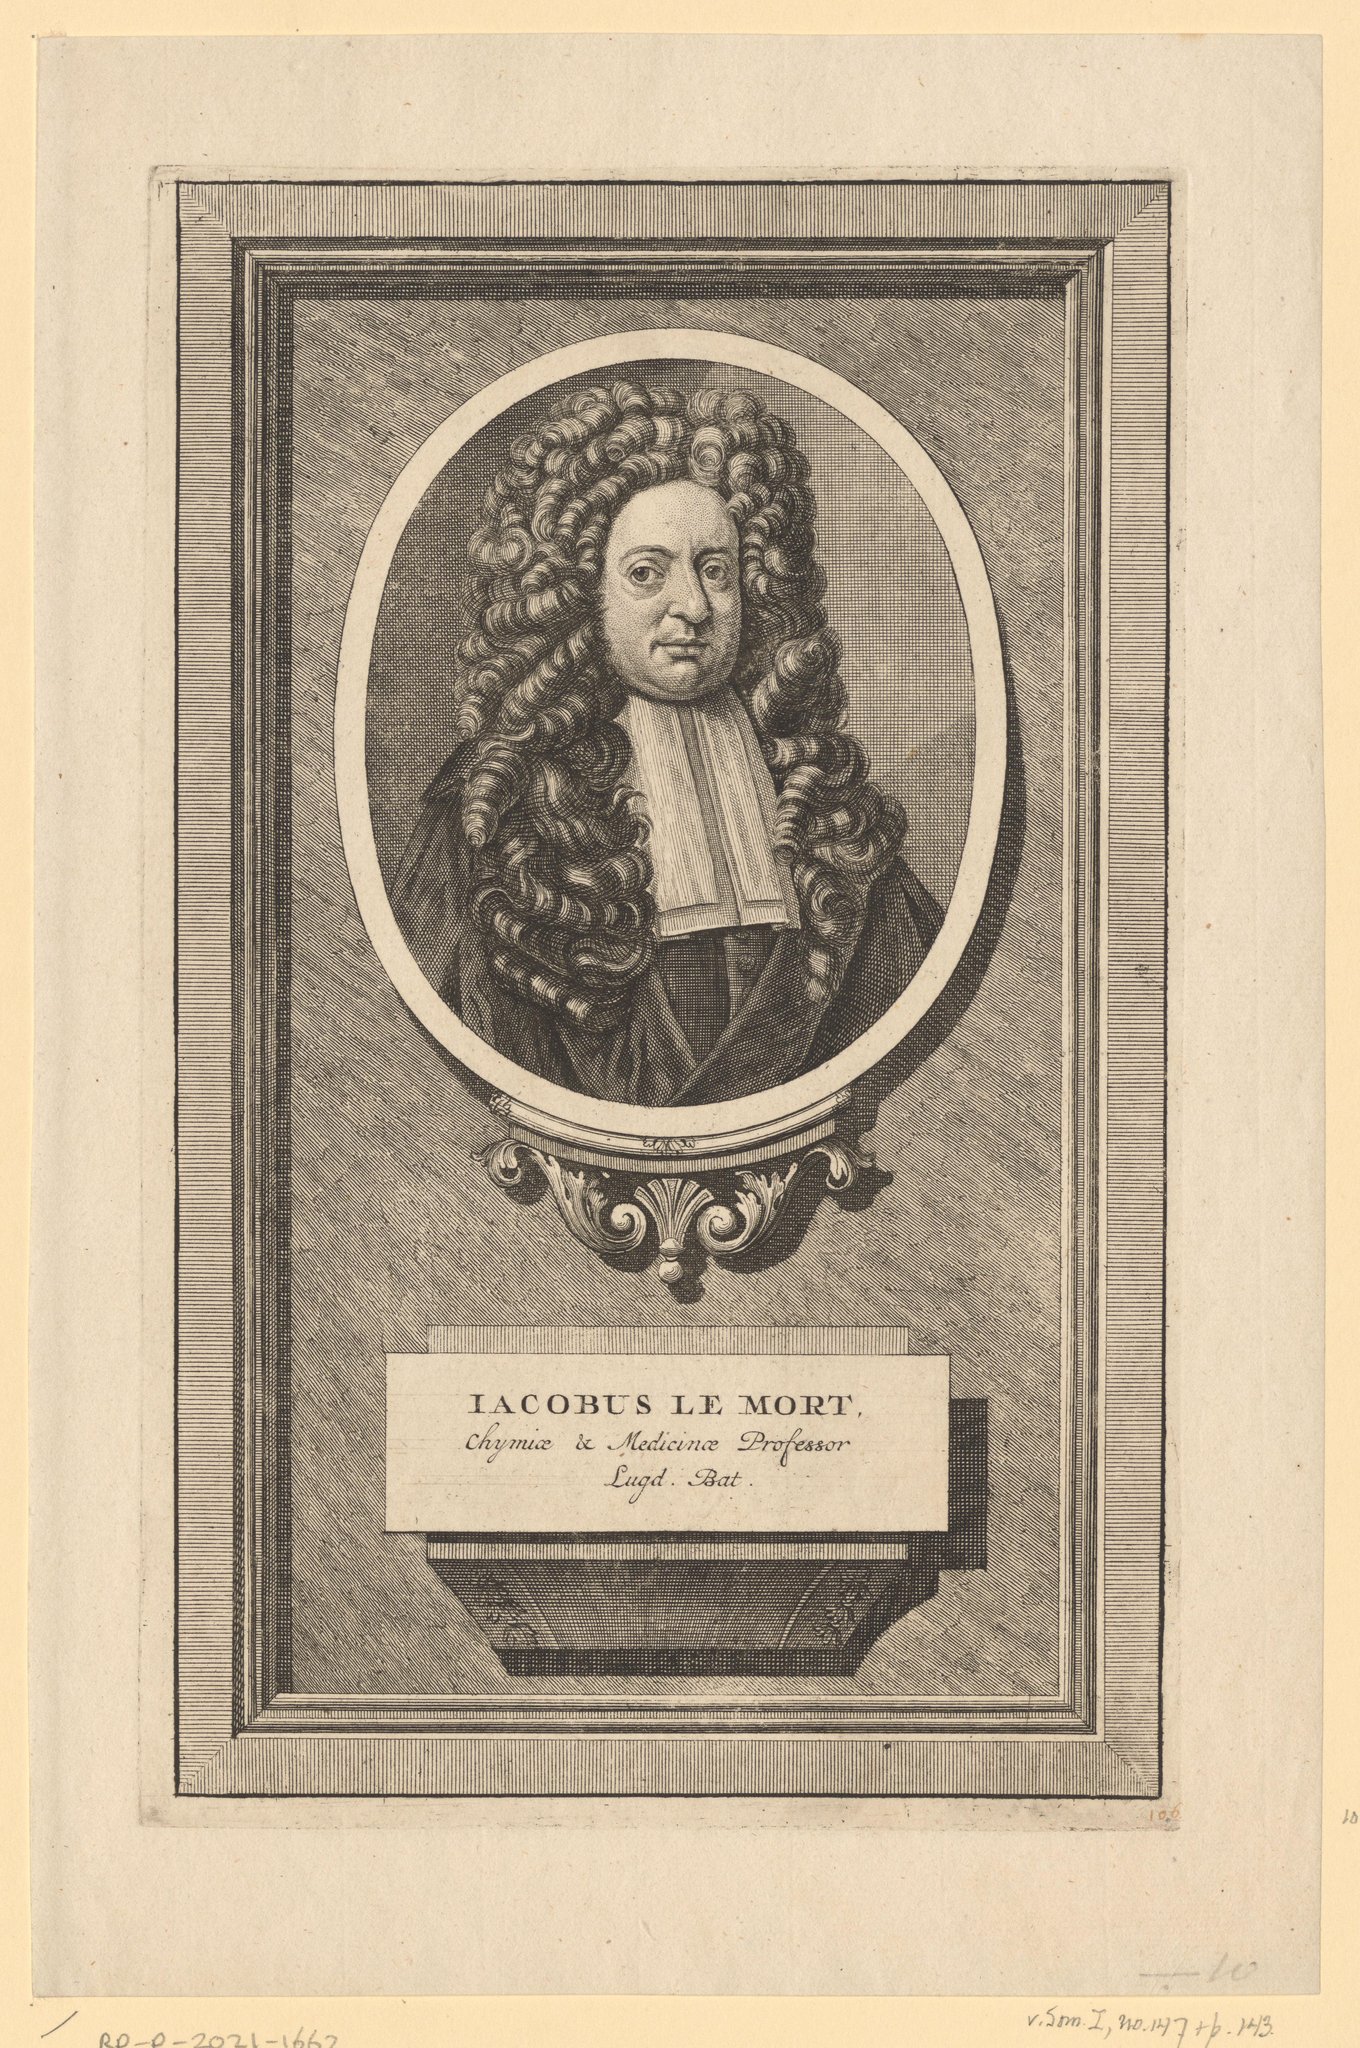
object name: print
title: Beroemde mannen aan de universiteit van Leiden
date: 1716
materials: paper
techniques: etching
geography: northern netherlands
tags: arnhem, leiden, ornament ~ medallion, historical persons, professor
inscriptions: number: ‘106’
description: Deze prent is zonder omlijsting gedrukt, zie voor een afdruk met omlijsting (van aparte plaat): RP-P-2021-1663.